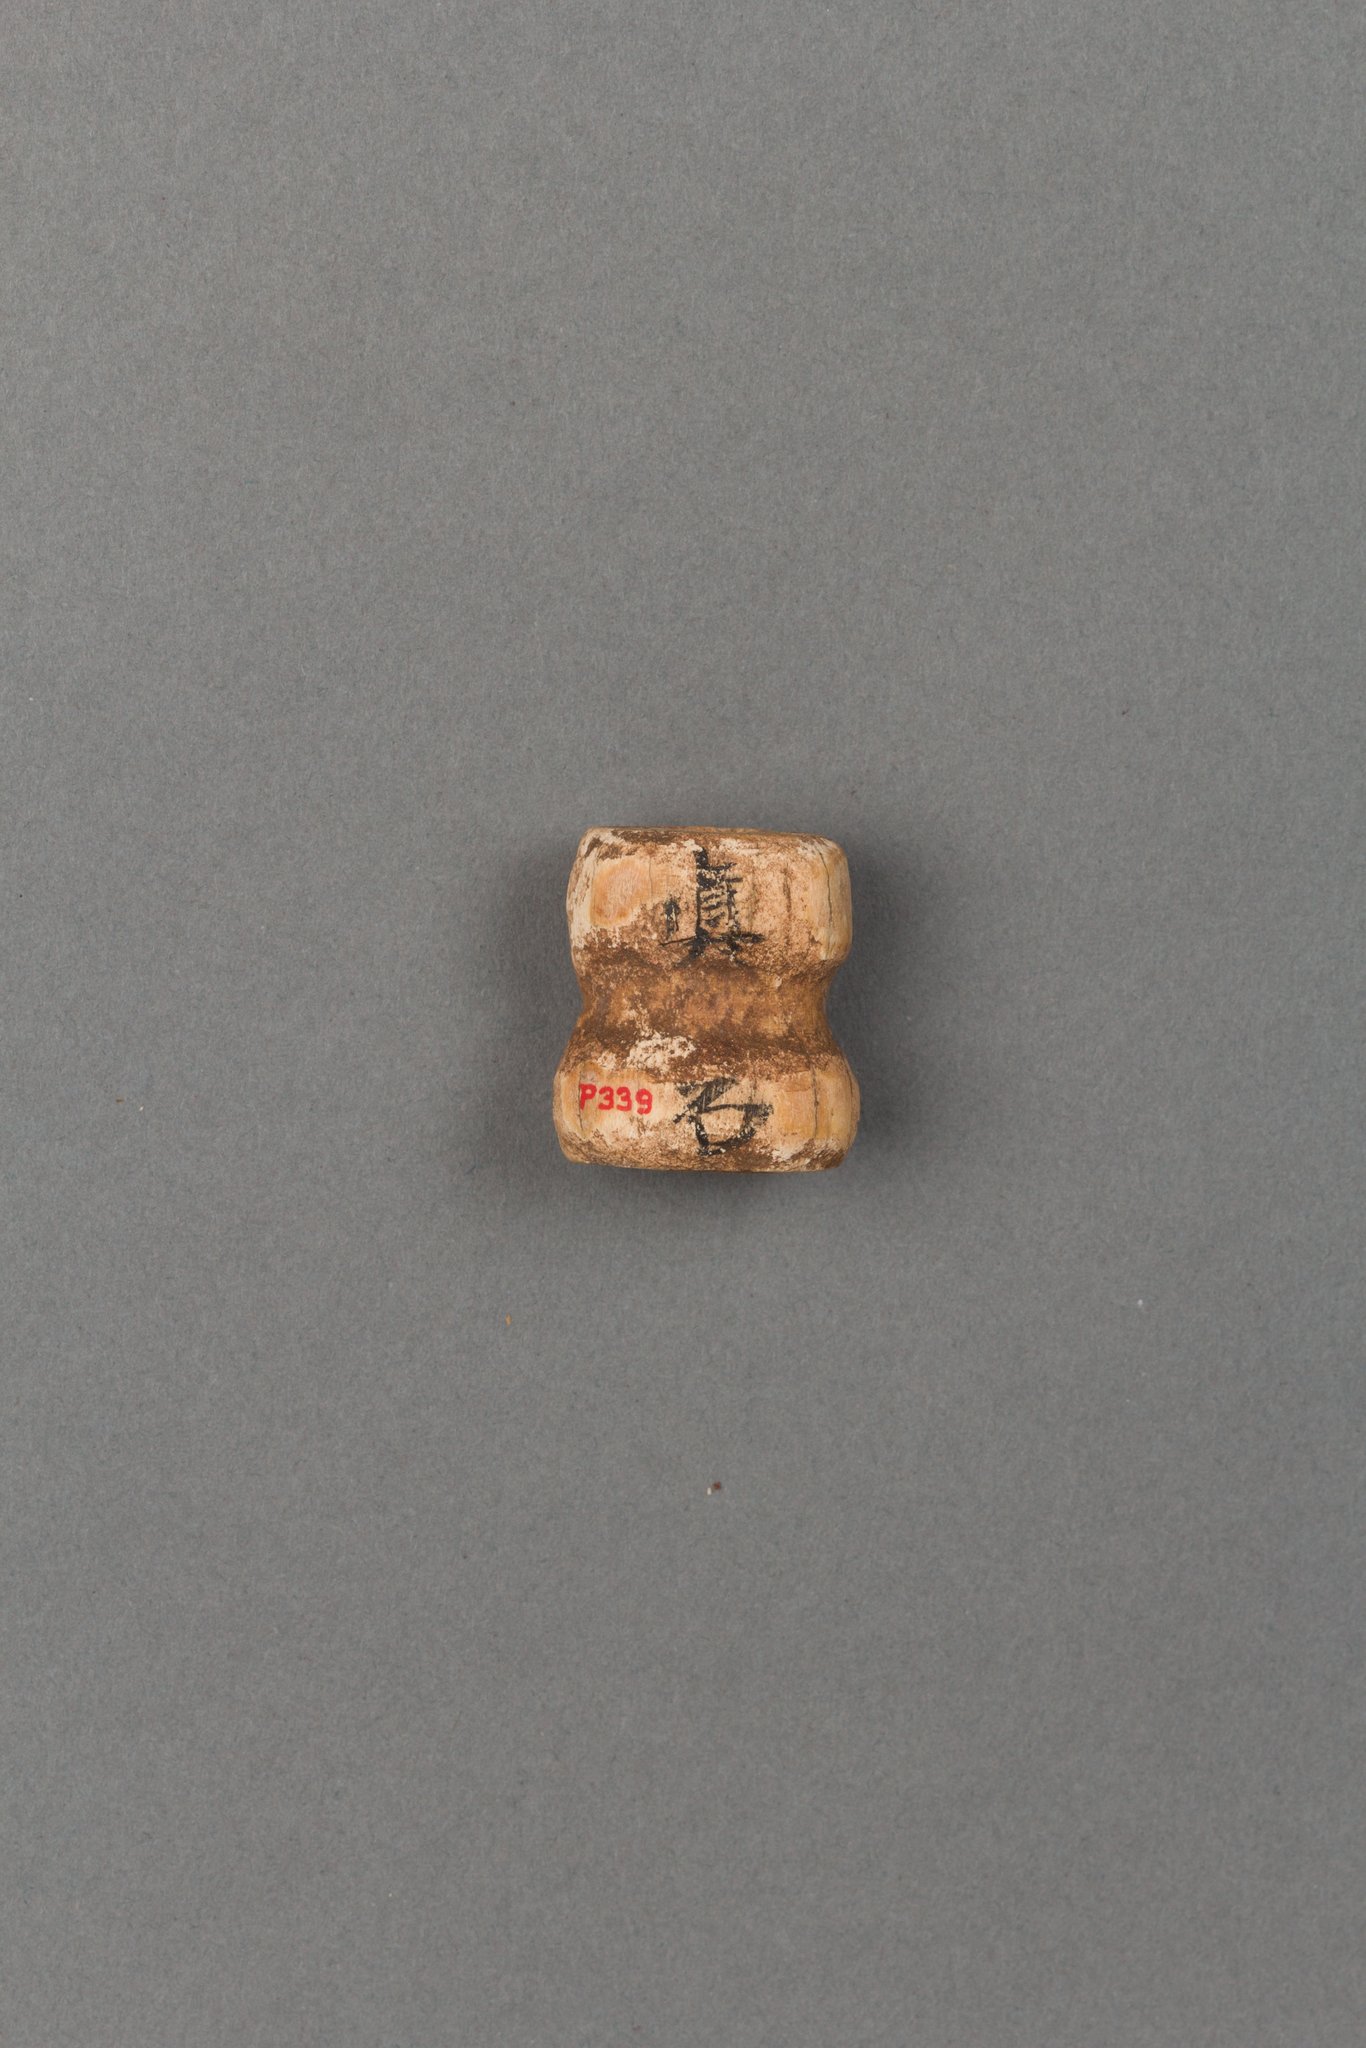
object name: earring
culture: japanese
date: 1200-200 BCE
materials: bone